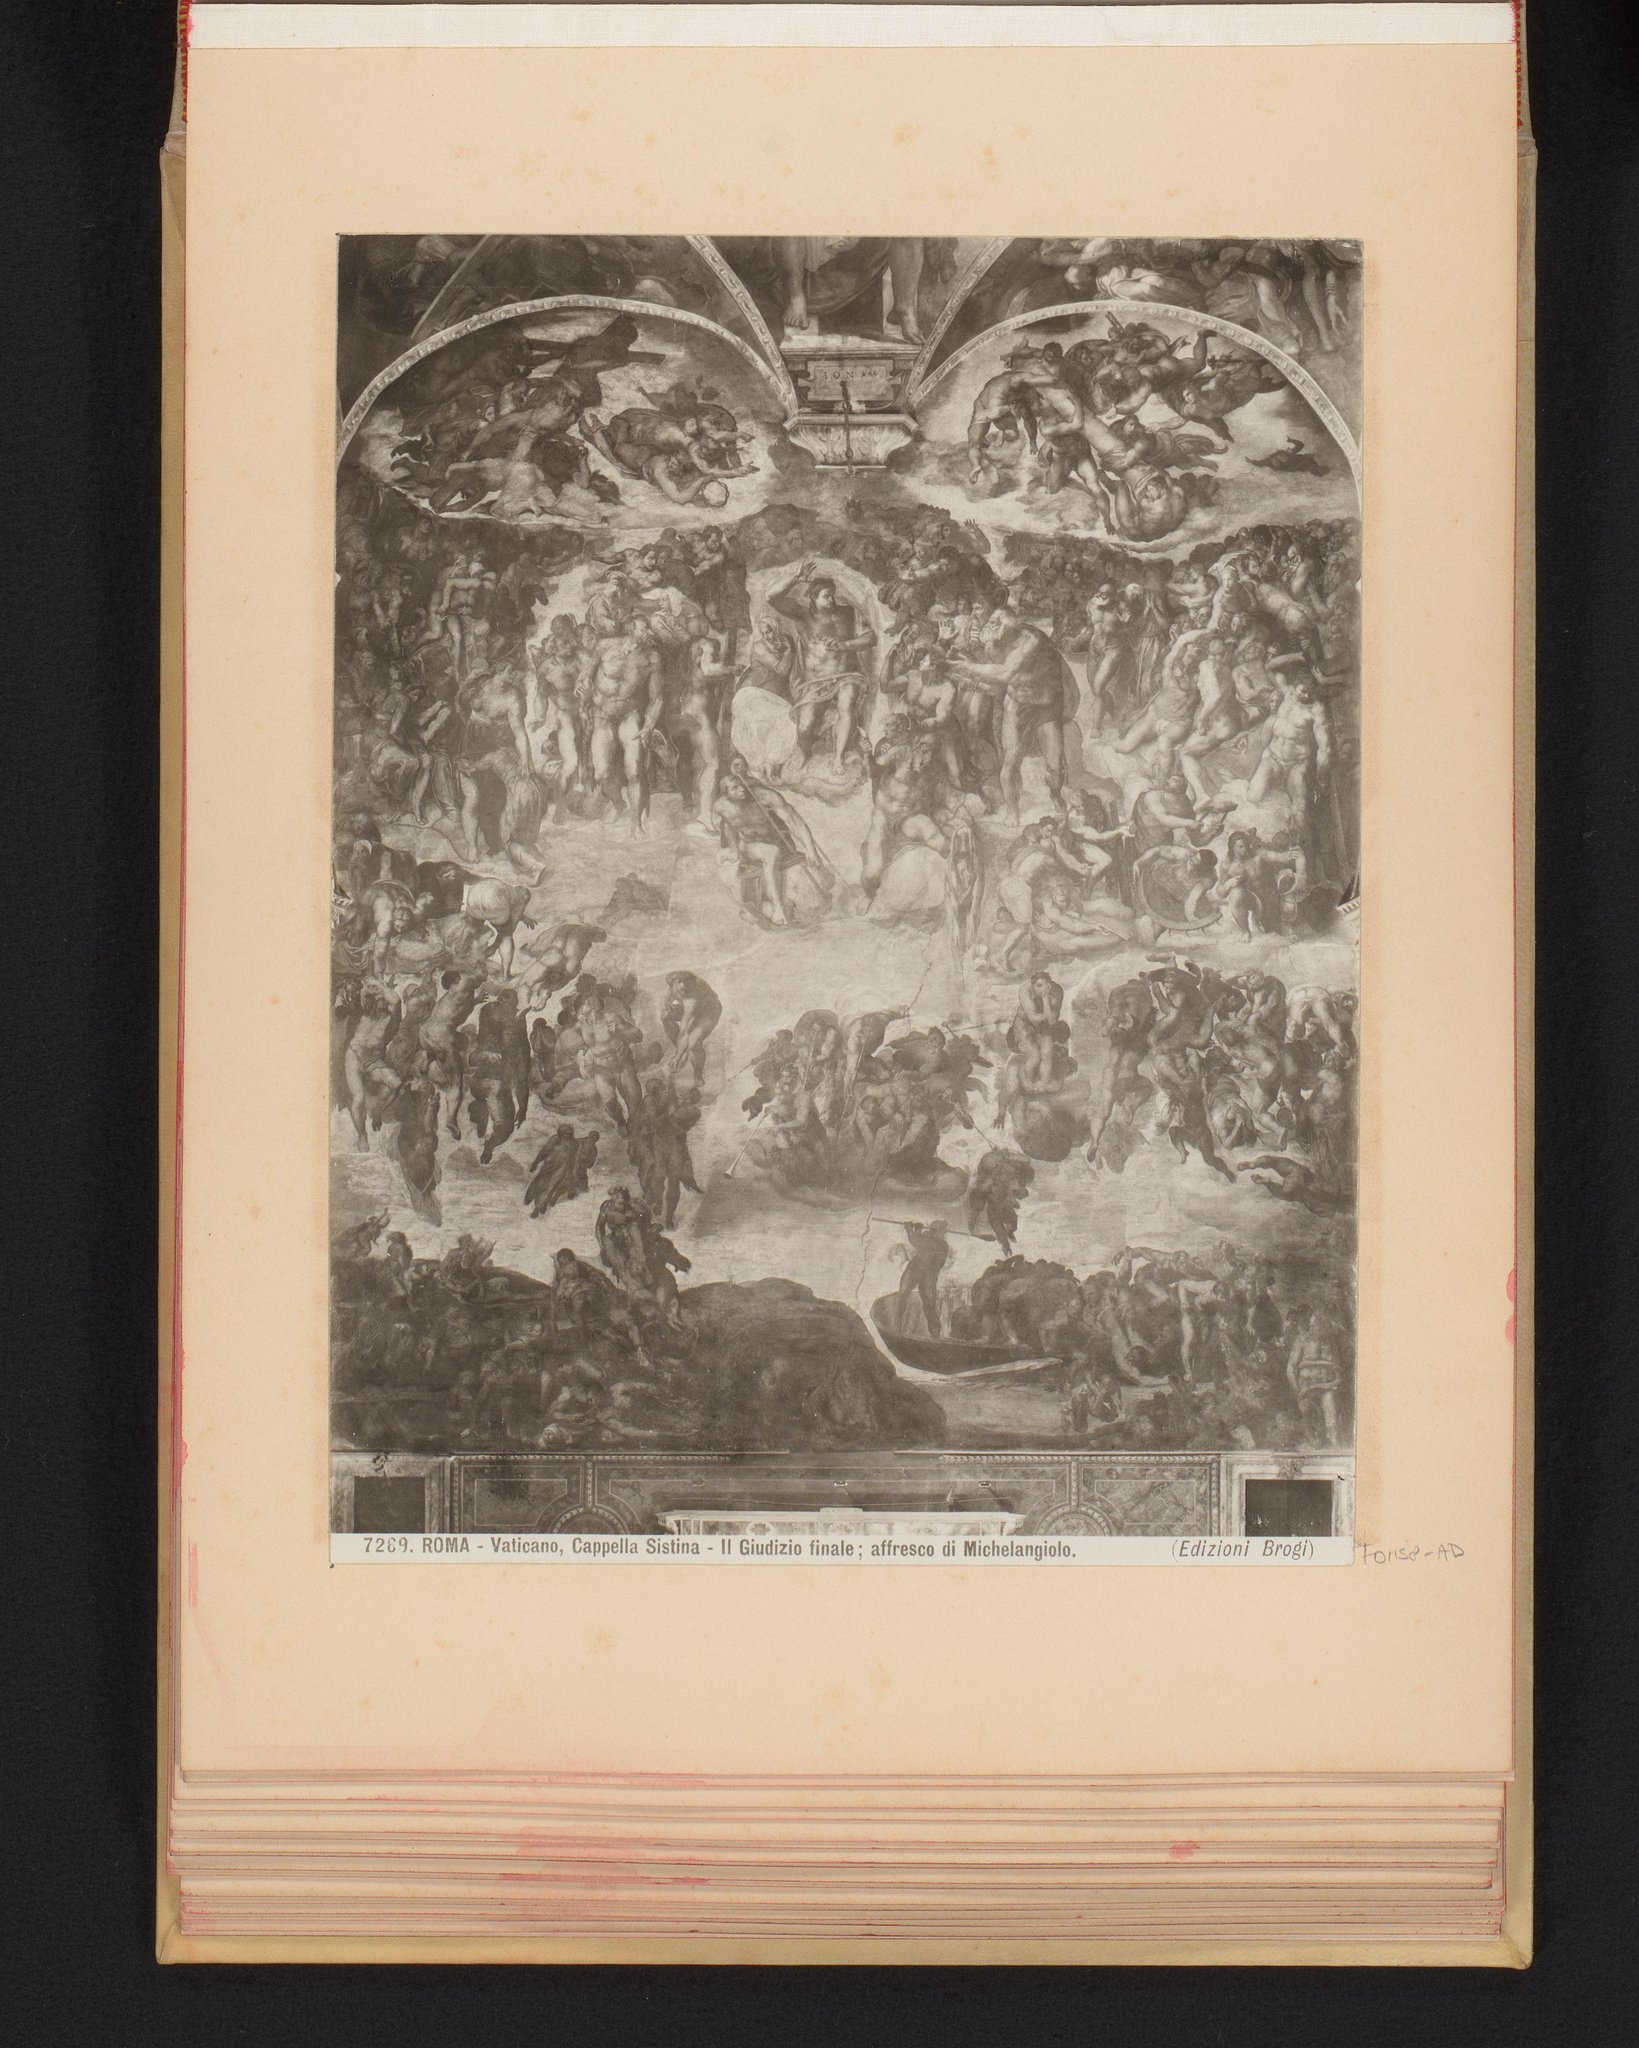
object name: photograph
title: Fresco in de Sixtijnse Kapel te Vaticaanstad, voorstellende het Laatste Oordeel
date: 1875-1907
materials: photographic support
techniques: gelatin silver print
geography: vatican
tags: the revelation of john, the apocalypse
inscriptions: number: ‘7269’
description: Onderdeel van Fotoalbum met opnames van bezienswaardigheden en kunstwerken in Italië.